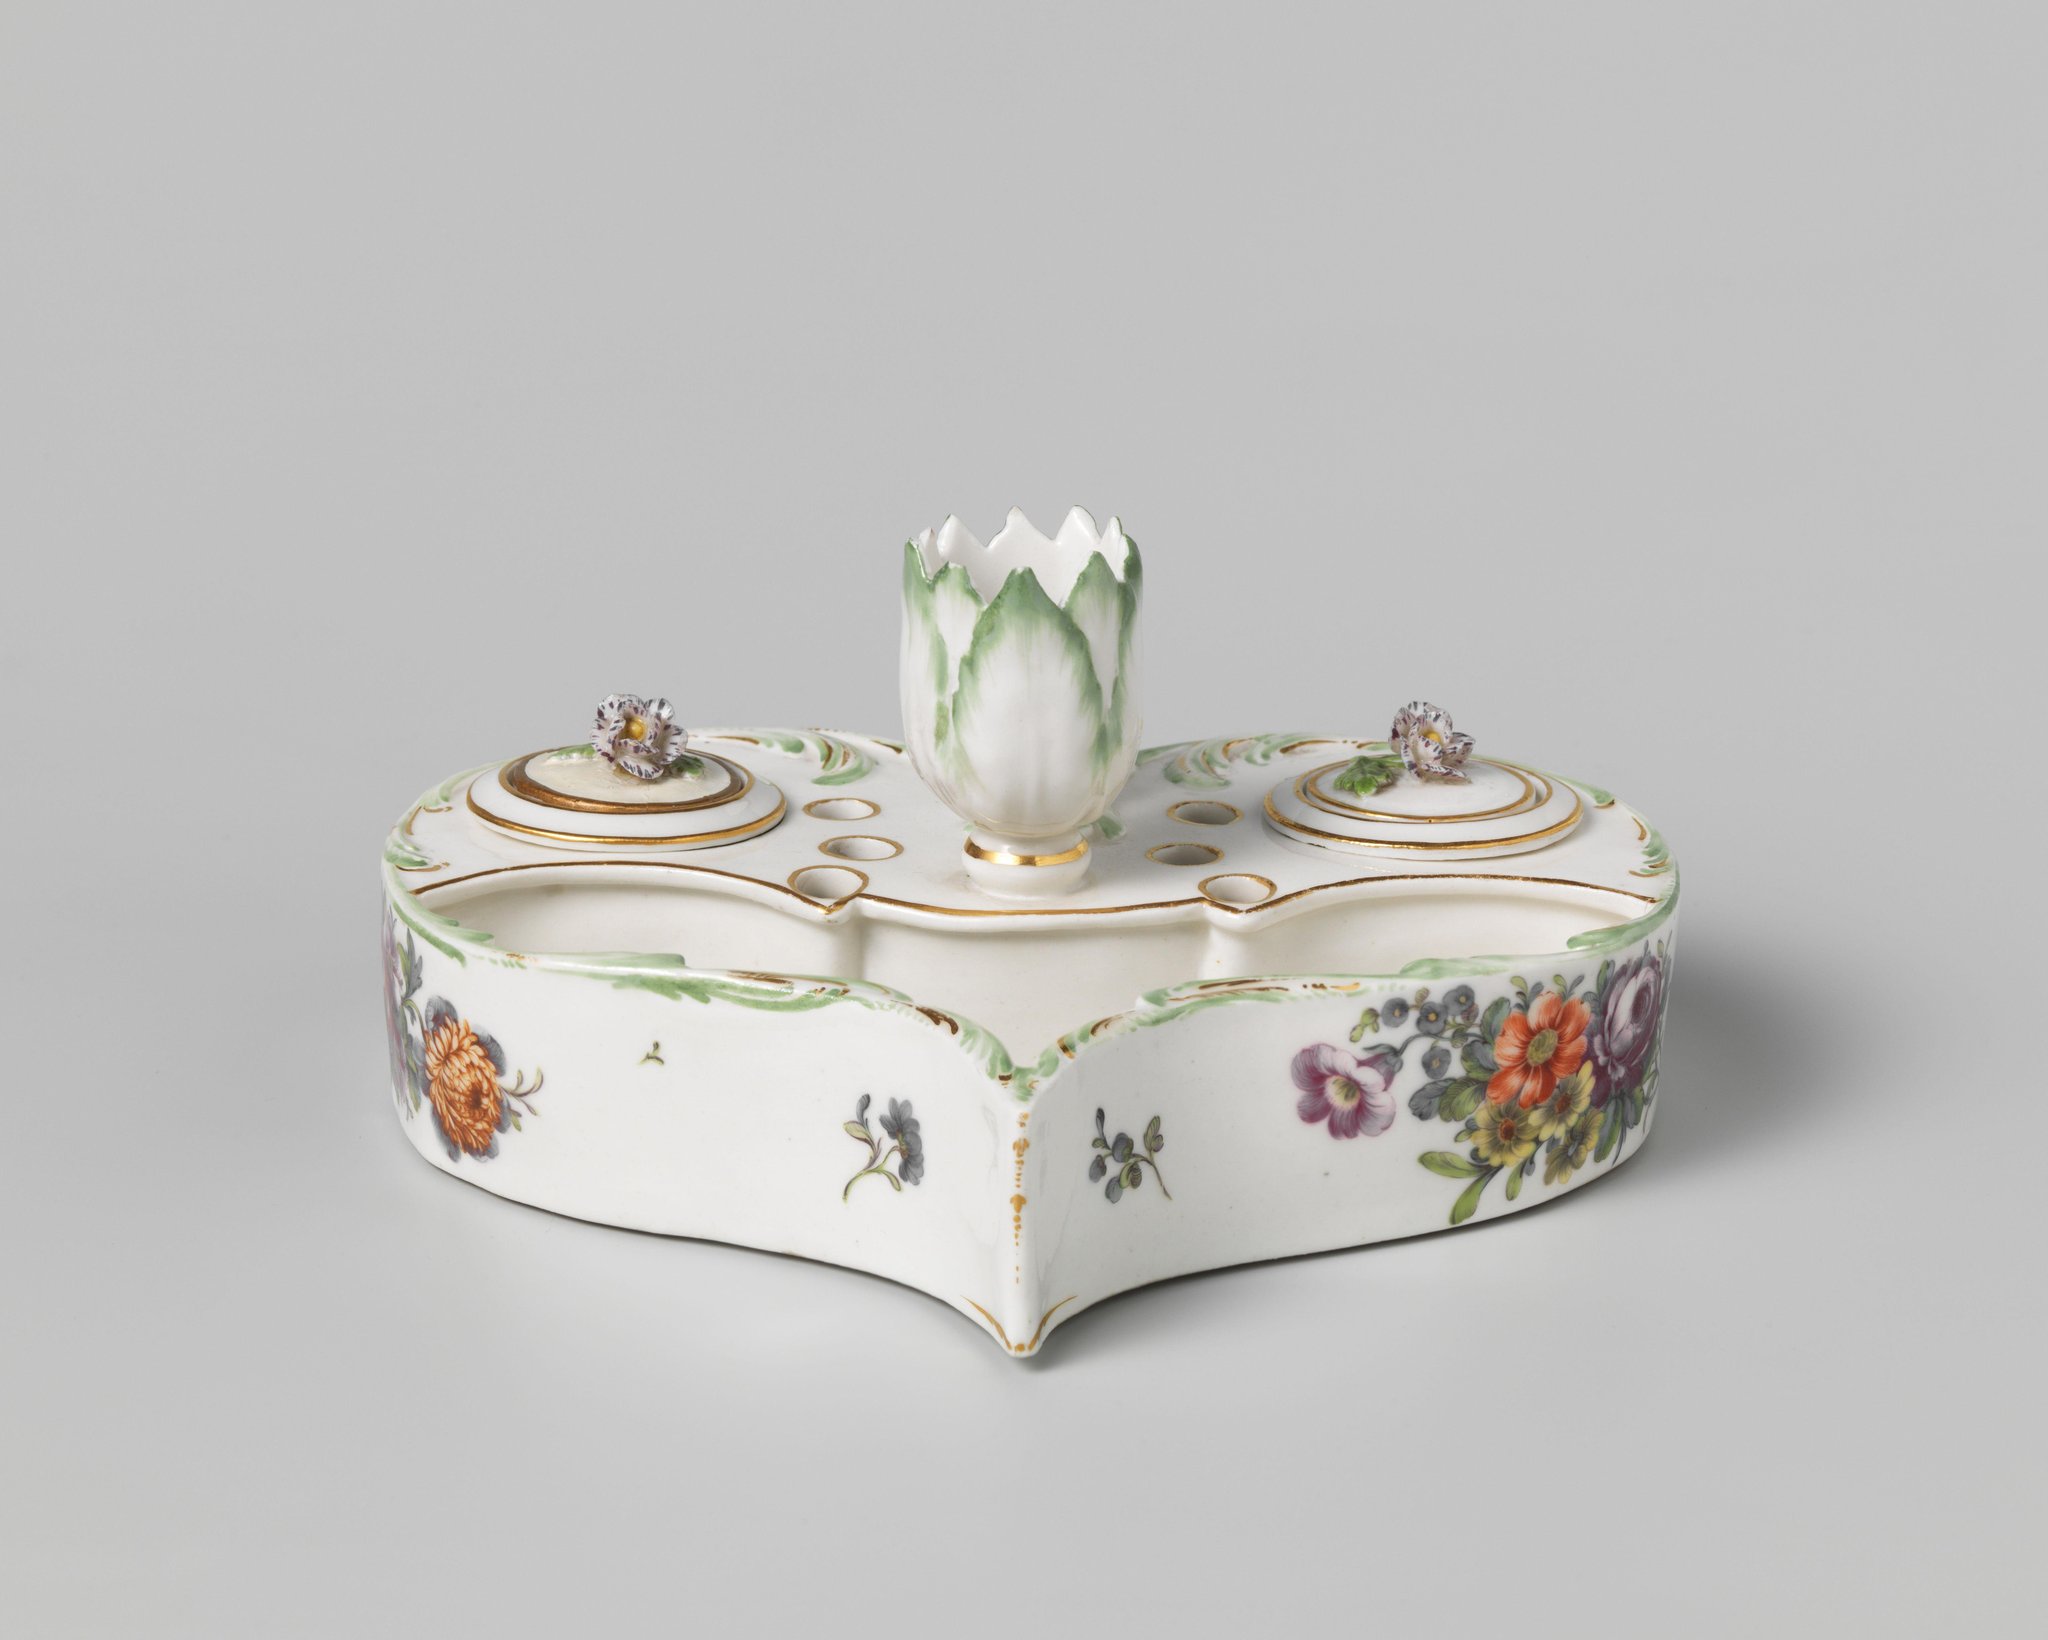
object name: inkstand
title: Inktpot met deksel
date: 1774-1778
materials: porcelain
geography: loosdrecht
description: In het gesloten deel twee ronde uitsparingen voor een inktpot en een zandstrooier, beide met dekseltje, waarop een plastische bloem aan een takje met bladeren in groen, geel en paars, en zes gaten voor pennen. Op de wand twee grote veelkleurige bloemboeketten en enkele losse bloemtakjes. Gouden biezen langs de randen van inktpot en zandstrooier en hun dekseltjes.